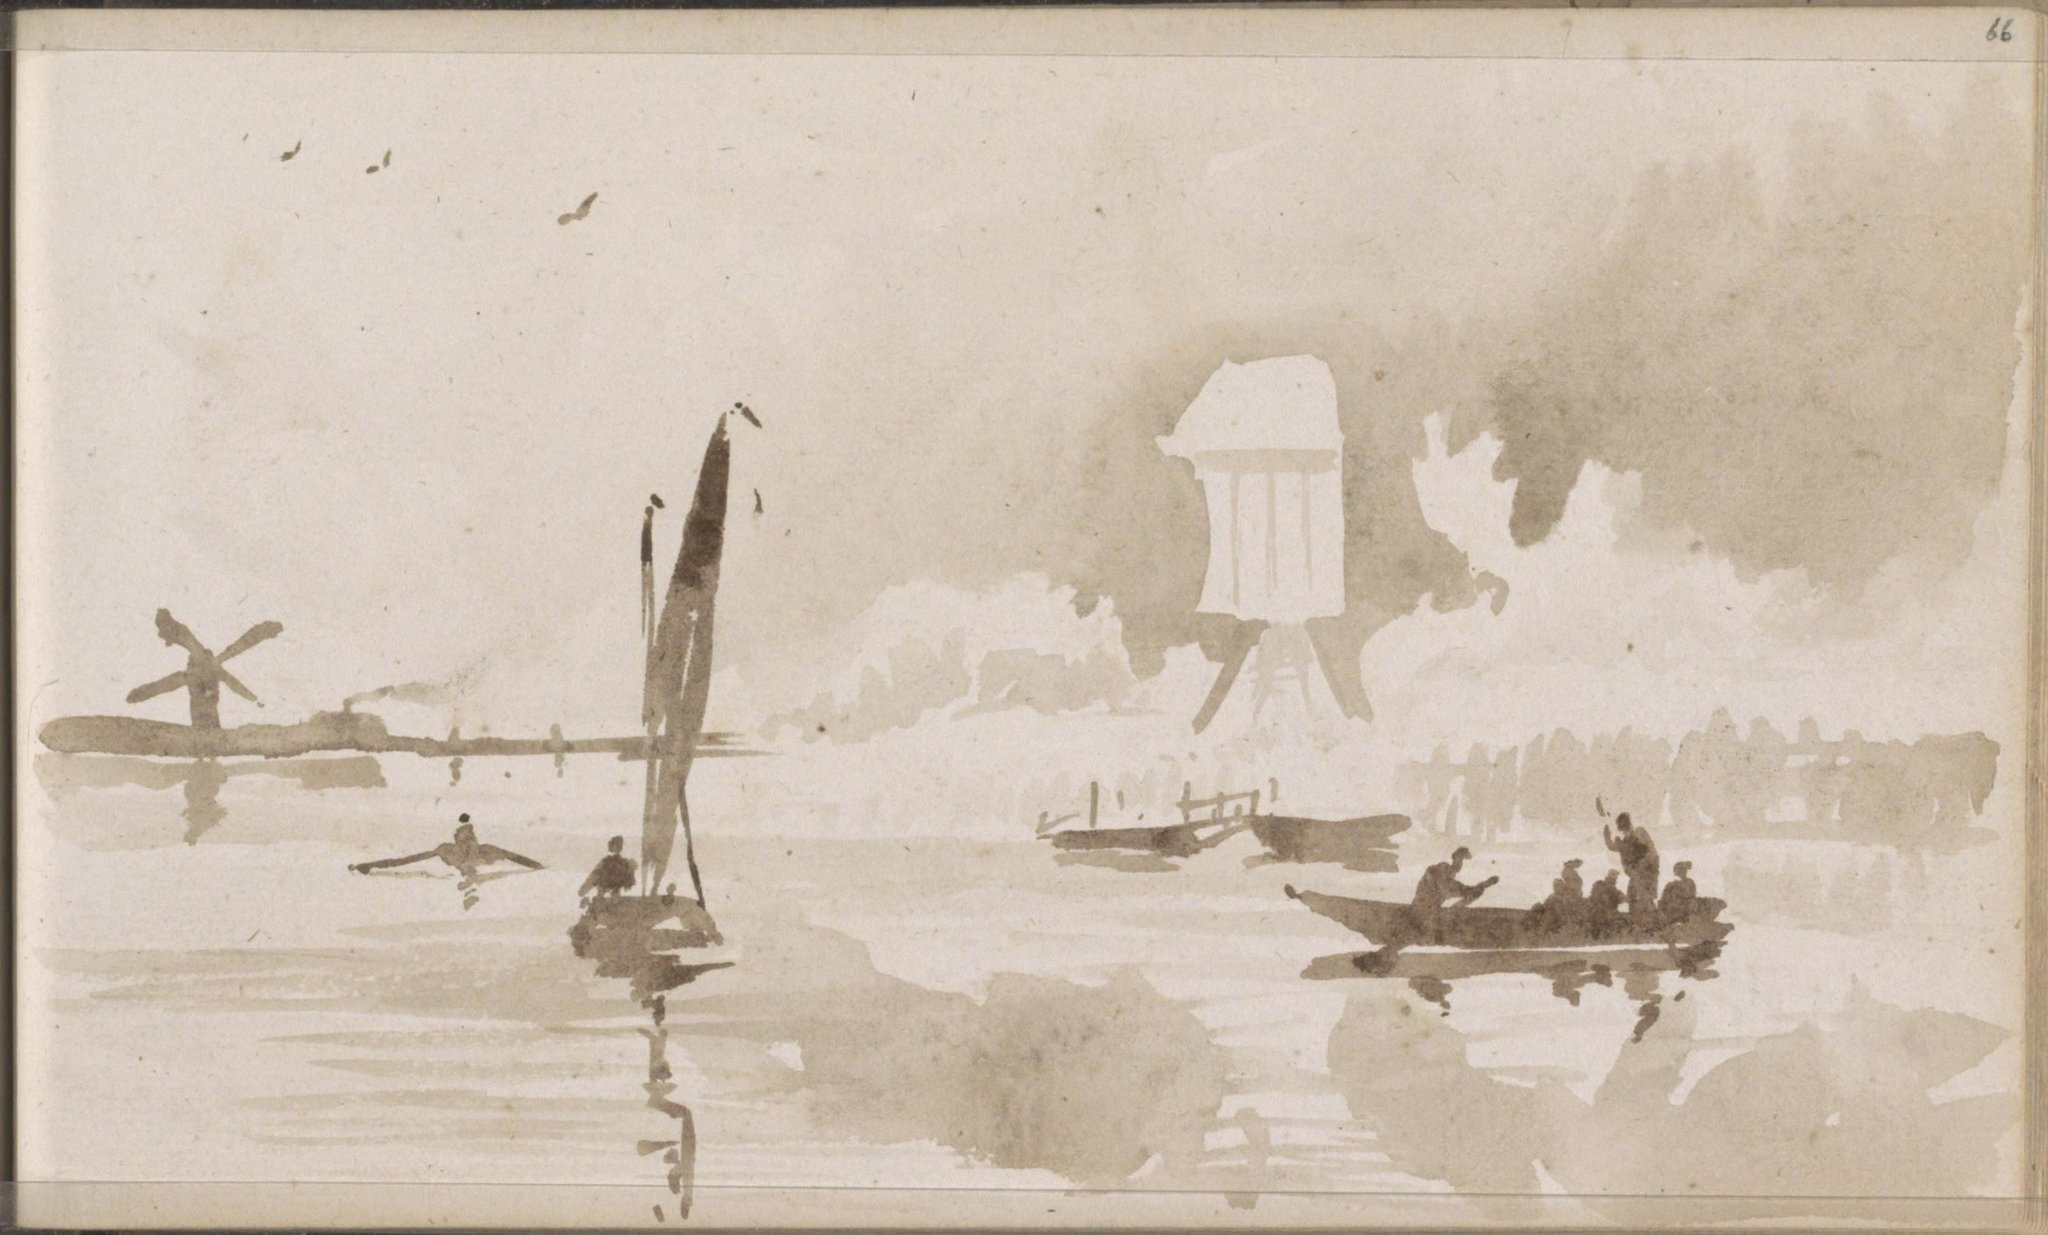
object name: sketchbook leaf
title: Rivierlandschap met molens en figuren in roeiboten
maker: johannes tavenraat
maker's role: draughtsman, painter, print maker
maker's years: 1809-1881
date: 1864-1880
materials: ink, paper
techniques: brush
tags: landscapes with waters, waterscapes, seascapes (in the temperate zone), rowing-boat, canoe, etc., windmill in landscape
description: Blad 66 recto uit een schetsboek met 98 bladen.